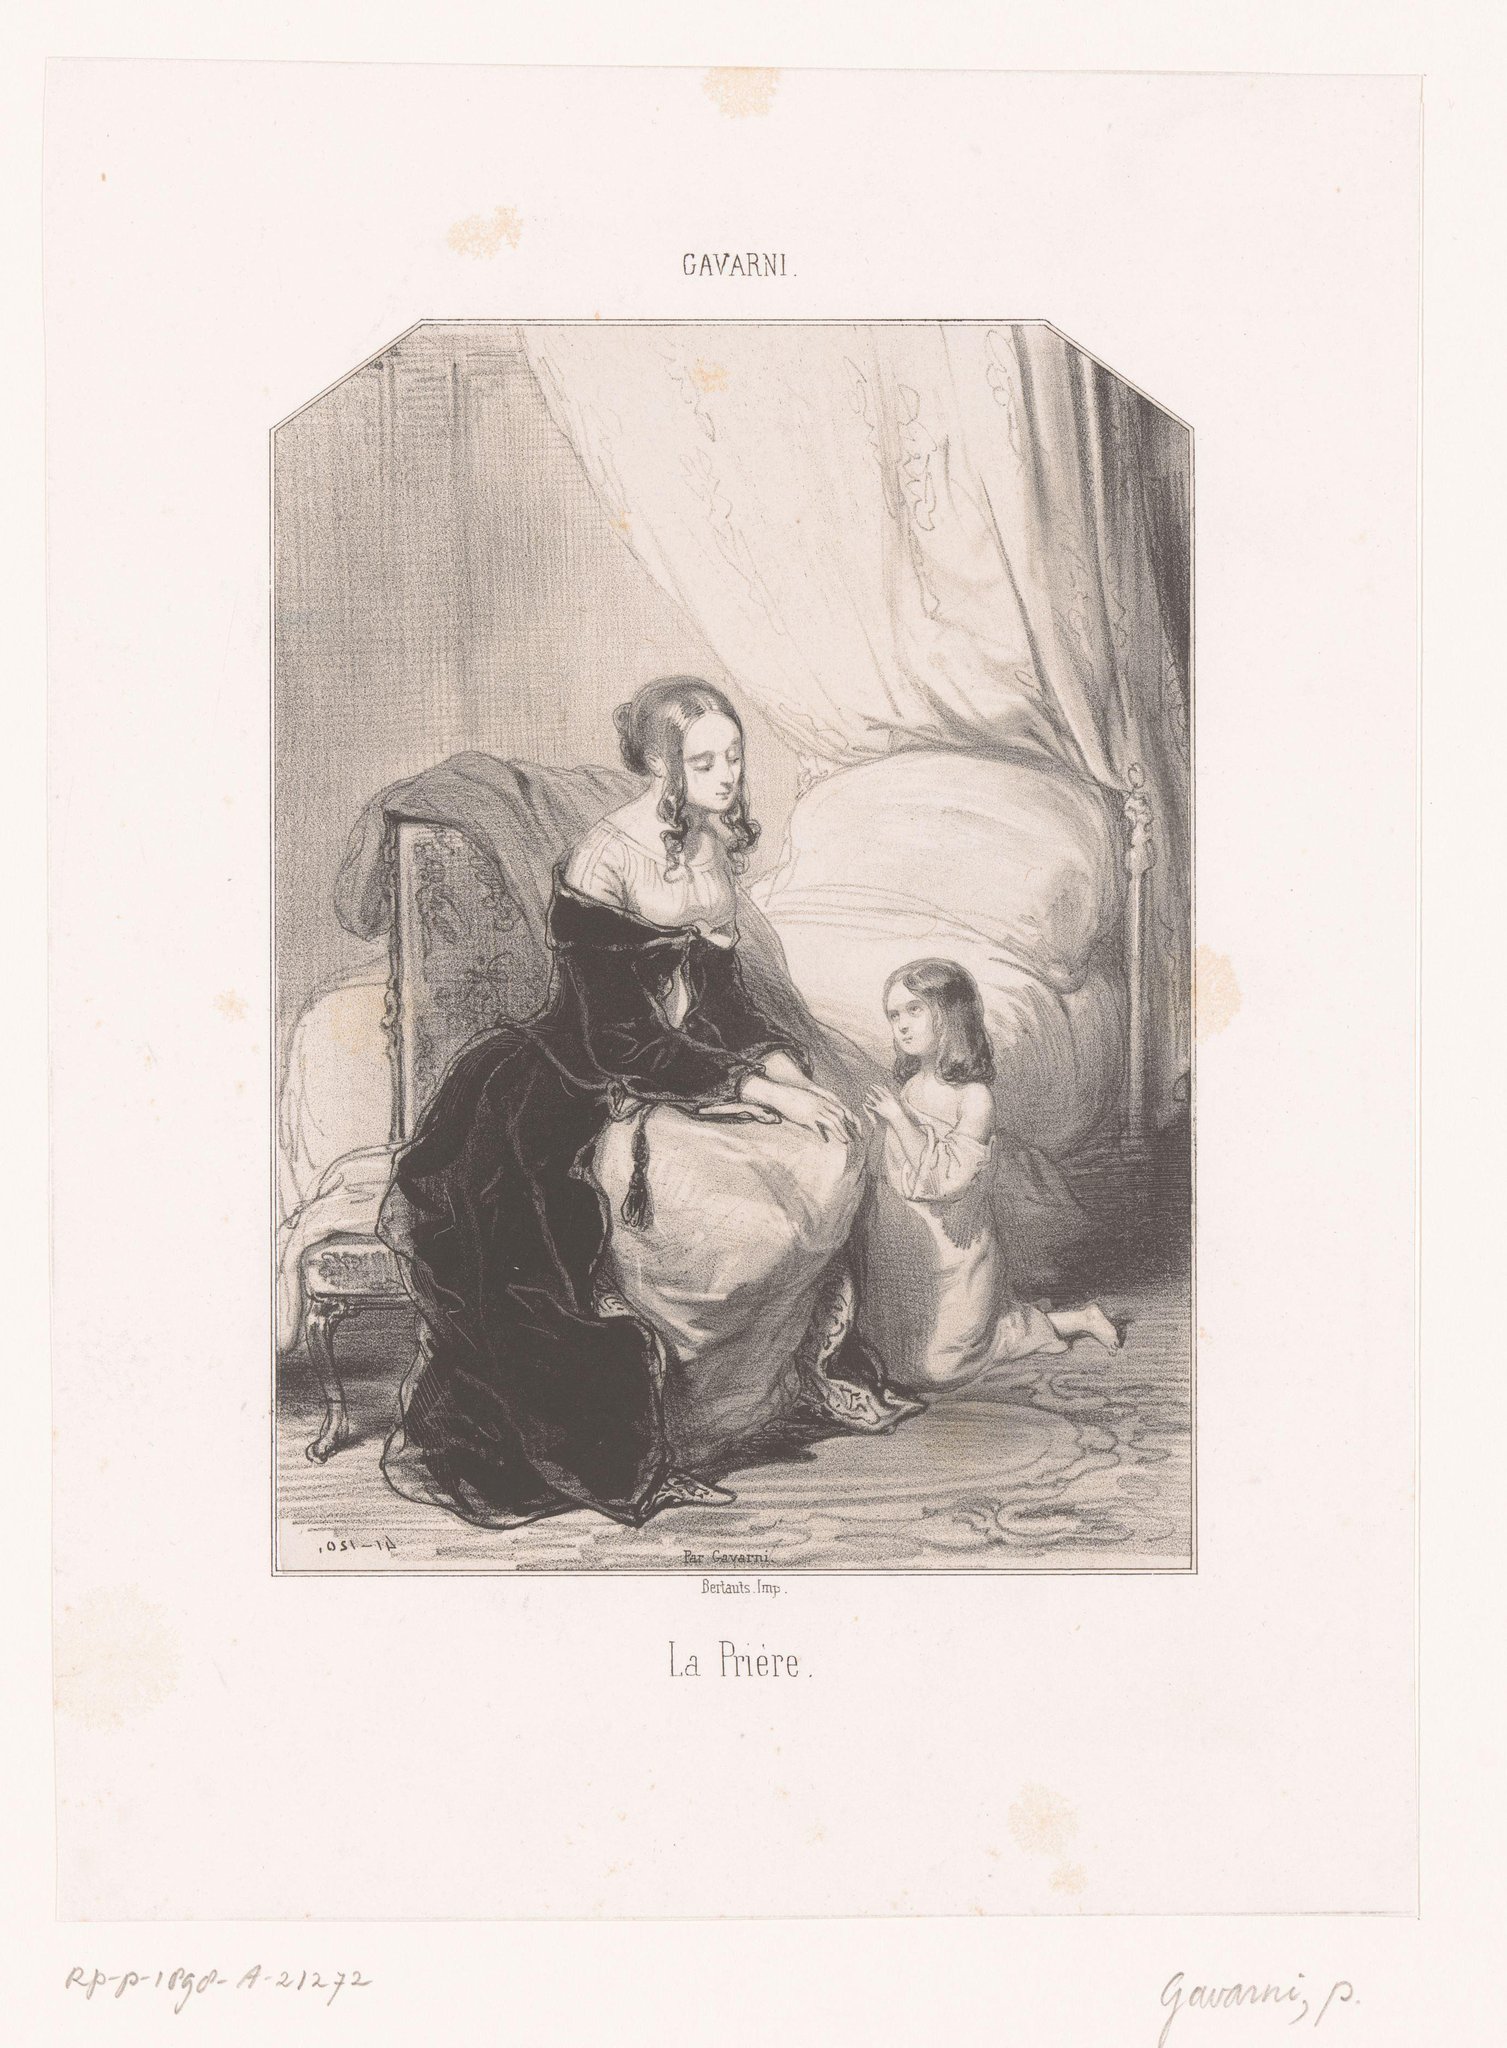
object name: print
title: Le Retour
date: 1843-1845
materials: paper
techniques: lithograph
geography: paris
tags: mother and daughter(s) (family group) (with number of daughters), one person praying, bedroom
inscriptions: collector's mark: Lugt 964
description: Prent gebruikt als illustratie voor de chansonnette Le Retour, in het album met bladmuziek Les Lys et les roses. Prent ook gebruikt voor: Curmer, L. Les Beaux-Arts. Illustration des Arts et de la Littérature. Parijs: L. Curmer, 1843. Vol. 1, 20e livraison. Prent eveneens gebruikt voor: Curmer, L. La Giralda. Parijs: L. Curmer, 1845.